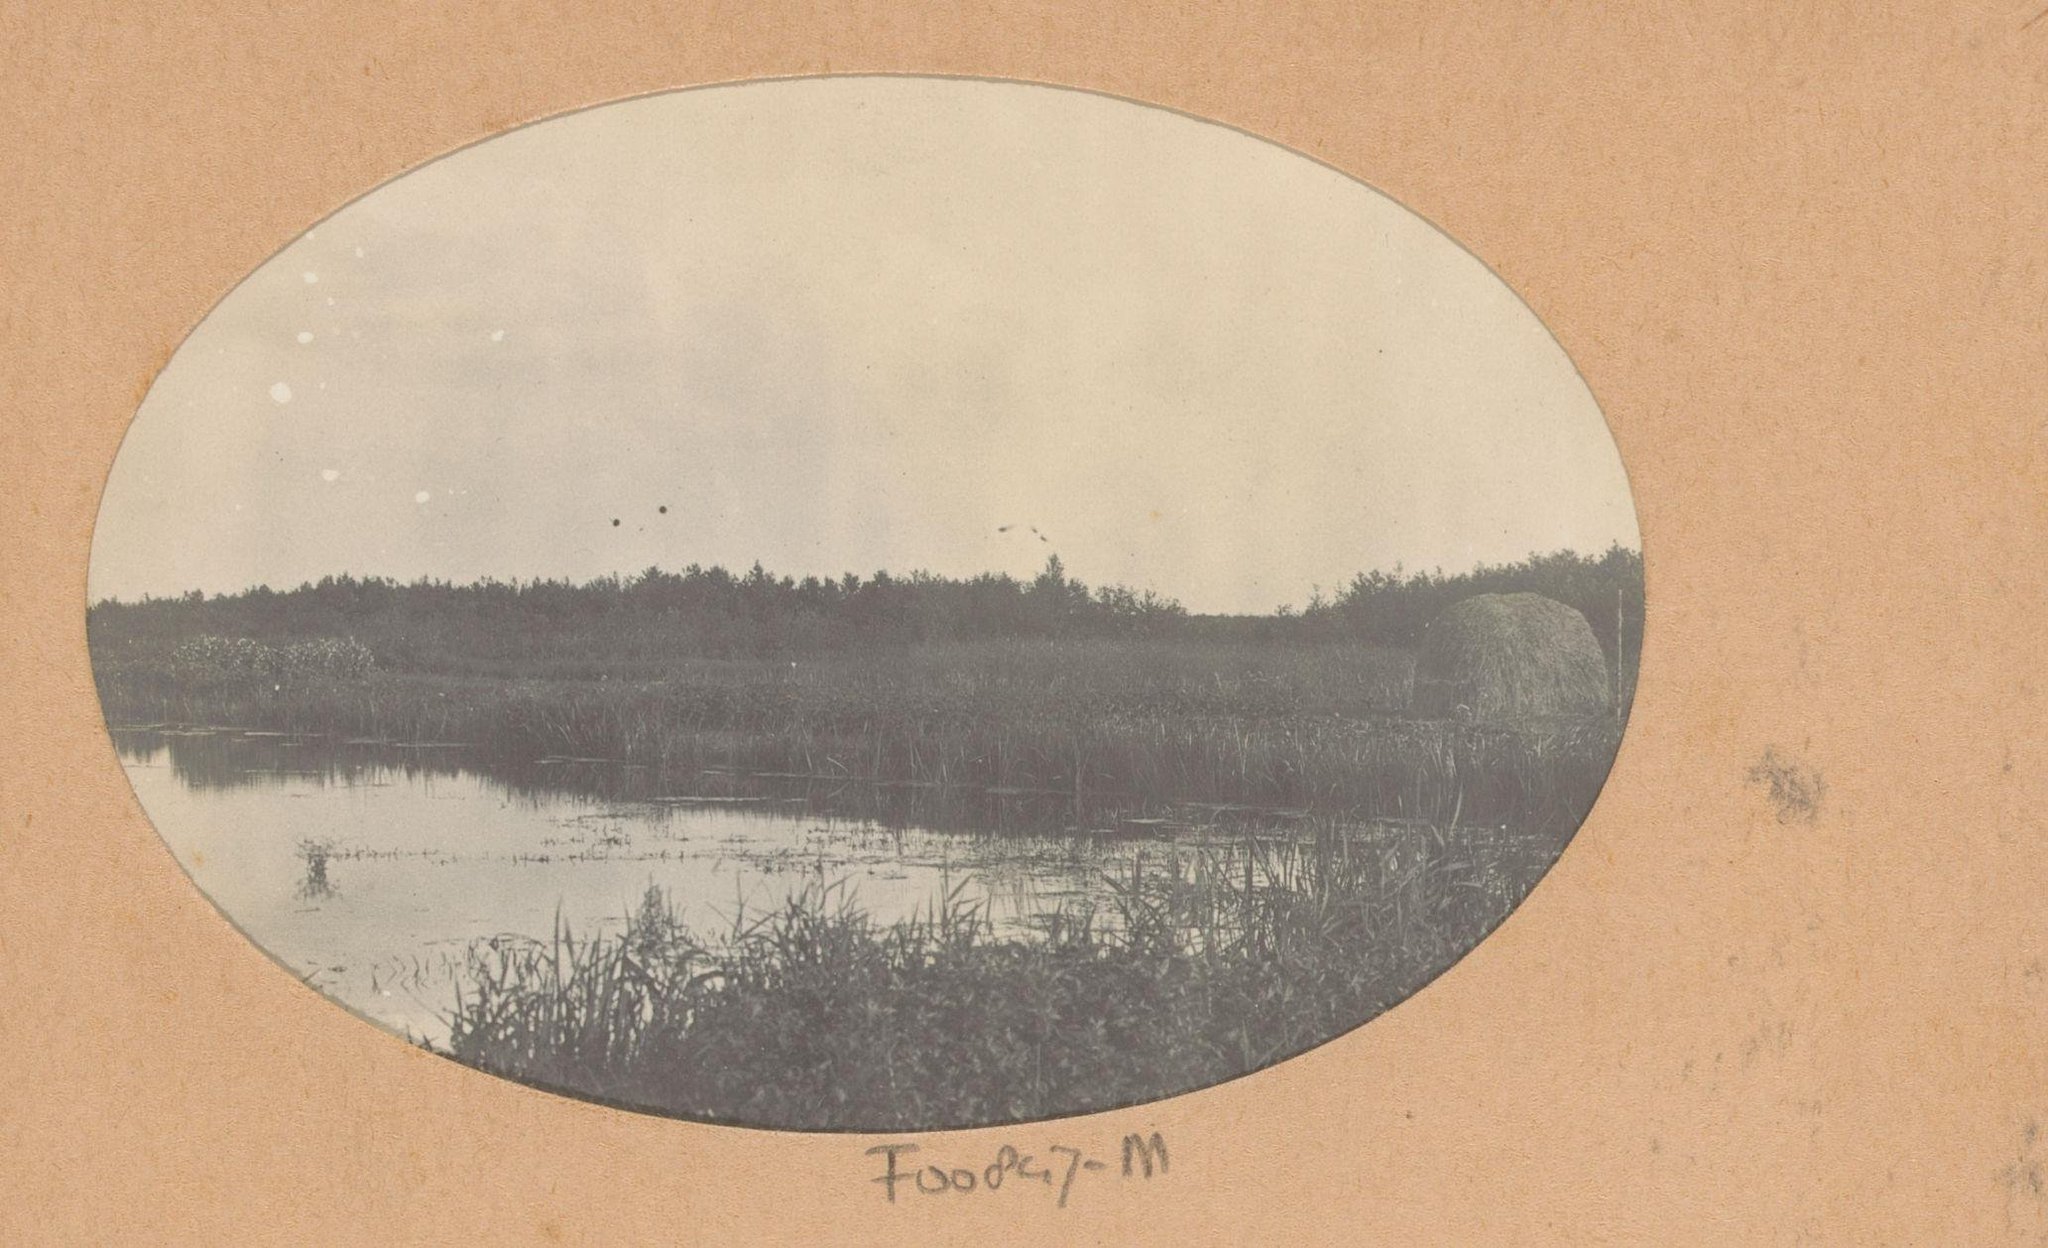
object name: album leaf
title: Landschap met een water, oeverbegroeiing en een hooiberg, vermoedelijk in Nederland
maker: Anonymous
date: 1902-1906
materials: cardboard, paper, photographic support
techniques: gelatin silver print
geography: netherlands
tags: landscapes with waters, waterscapes, seascapes (in the temperate zone), hay-stack, netherlands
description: Onderdeel van Reisalbum van een Nederlandse familie met bezienswaardigheden in Europa, Egypte en New York.